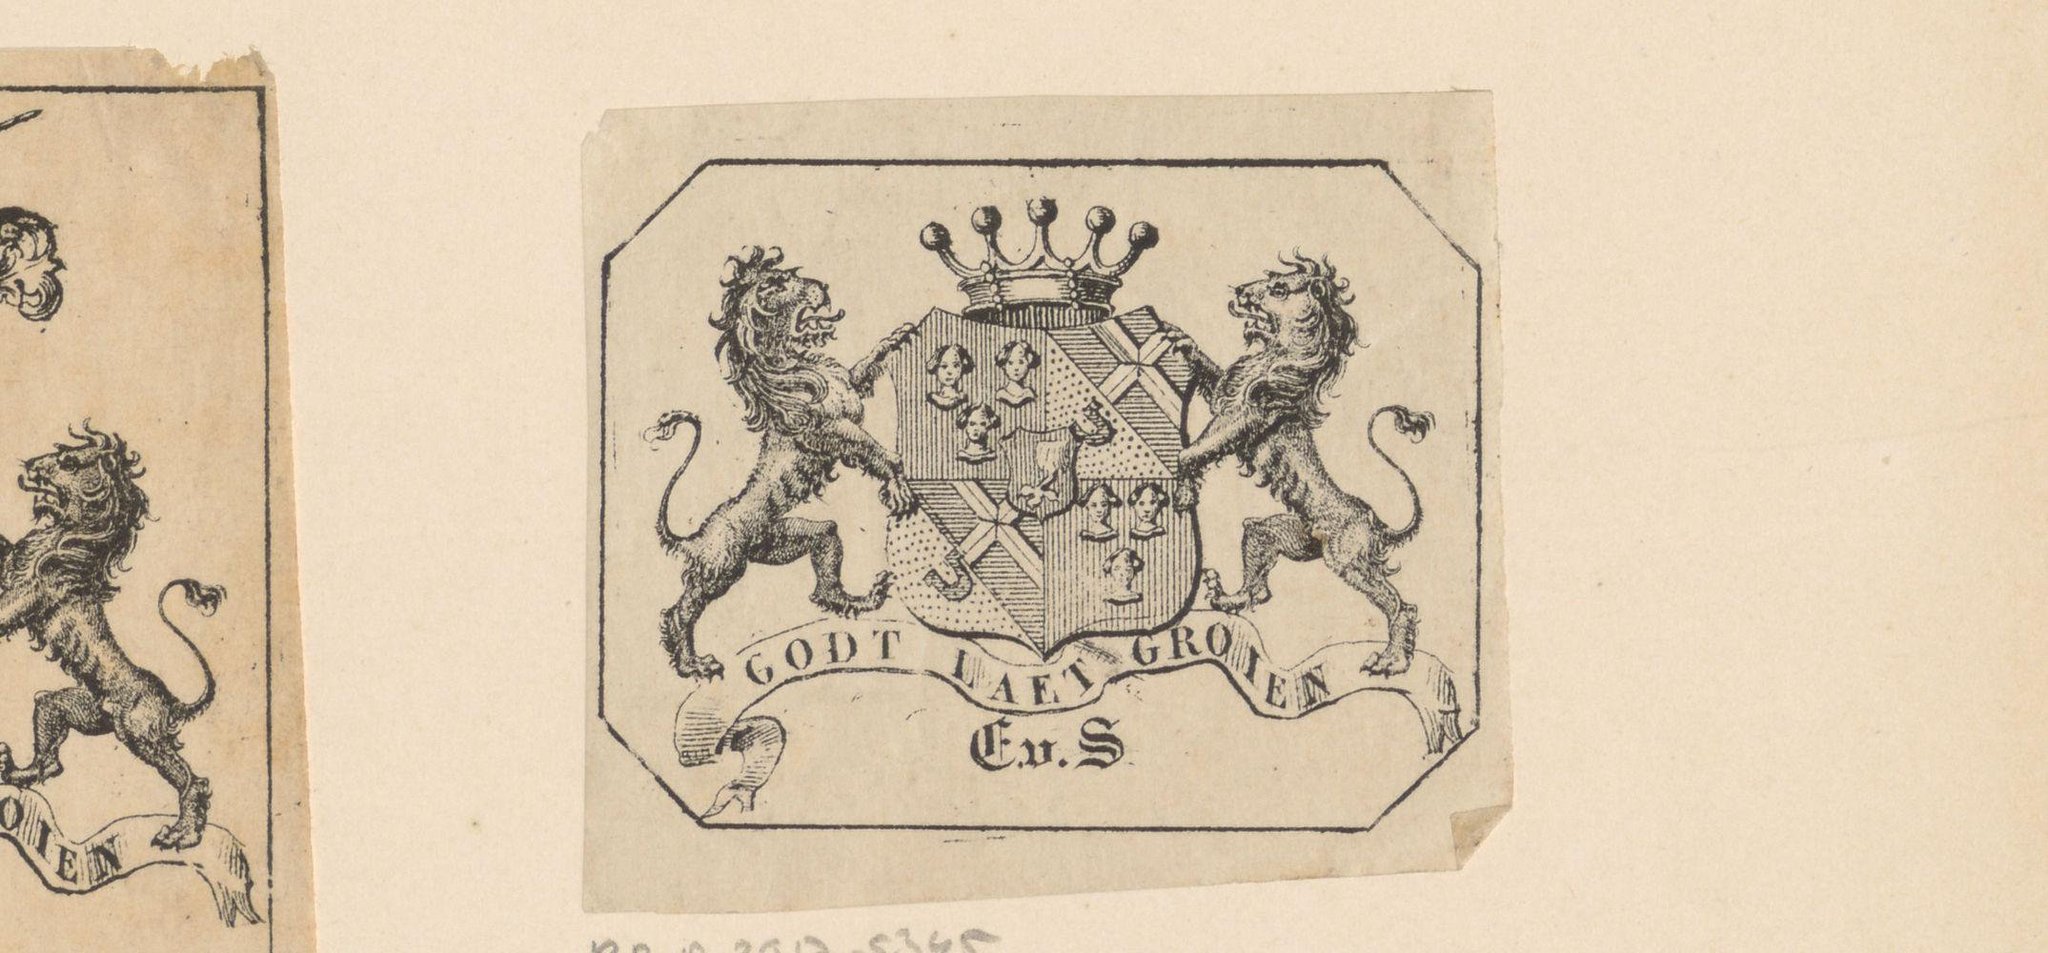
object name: bookplate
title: Godt laet groeien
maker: Anonymous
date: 1800-1899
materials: paper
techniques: printing block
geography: netherlands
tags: head (human) - aa - female human figure, beasts of prey, predatory animals: lion, armorial bearing, heraldry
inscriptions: inscription: ‘Rietstap, 608.’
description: Ex libris van de familie Elout van Soeterwoude.